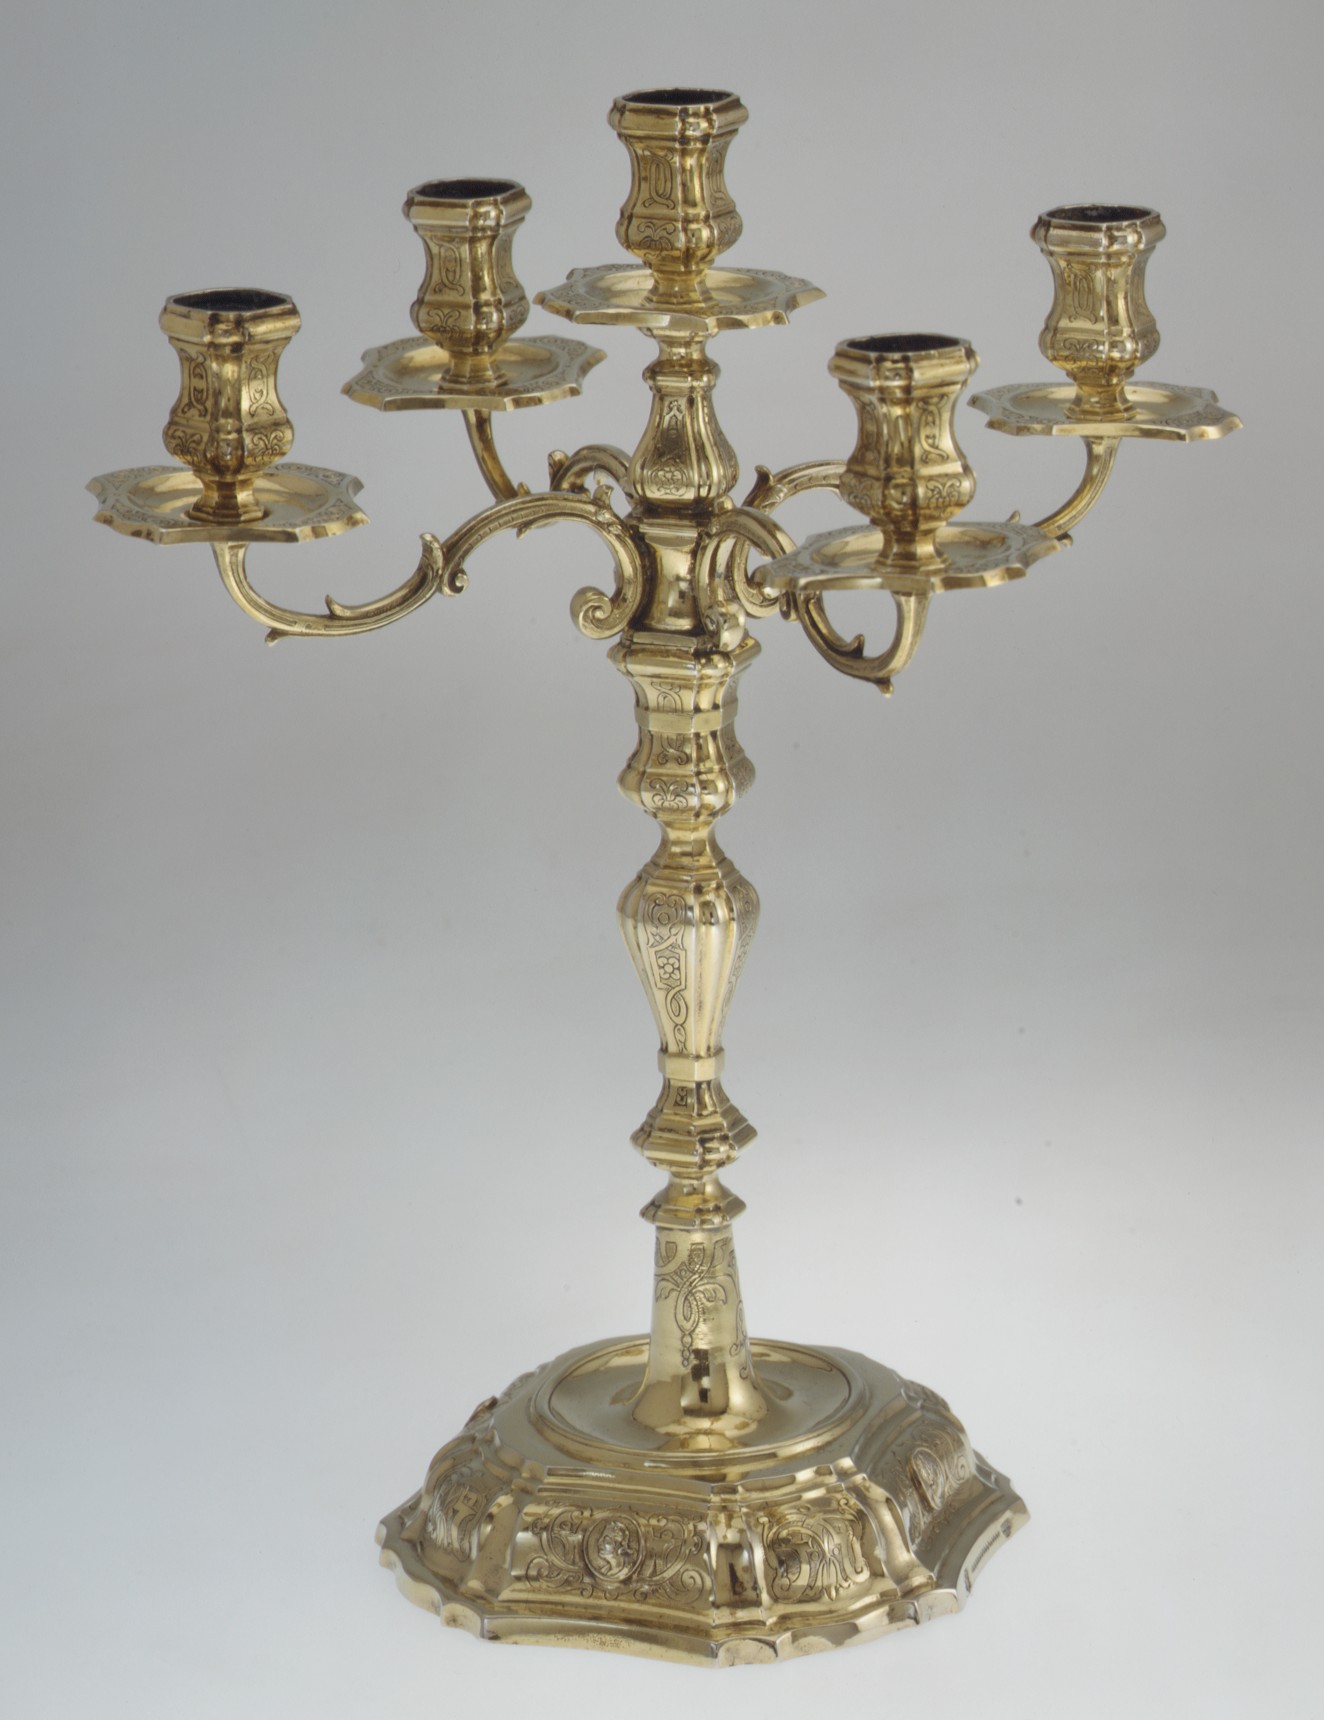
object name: candelabrum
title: Candelabrum (one of a pair)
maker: daniel friedrich metius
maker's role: maker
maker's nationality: german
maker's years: 1696-1770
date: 1726-1750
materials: silver gilt